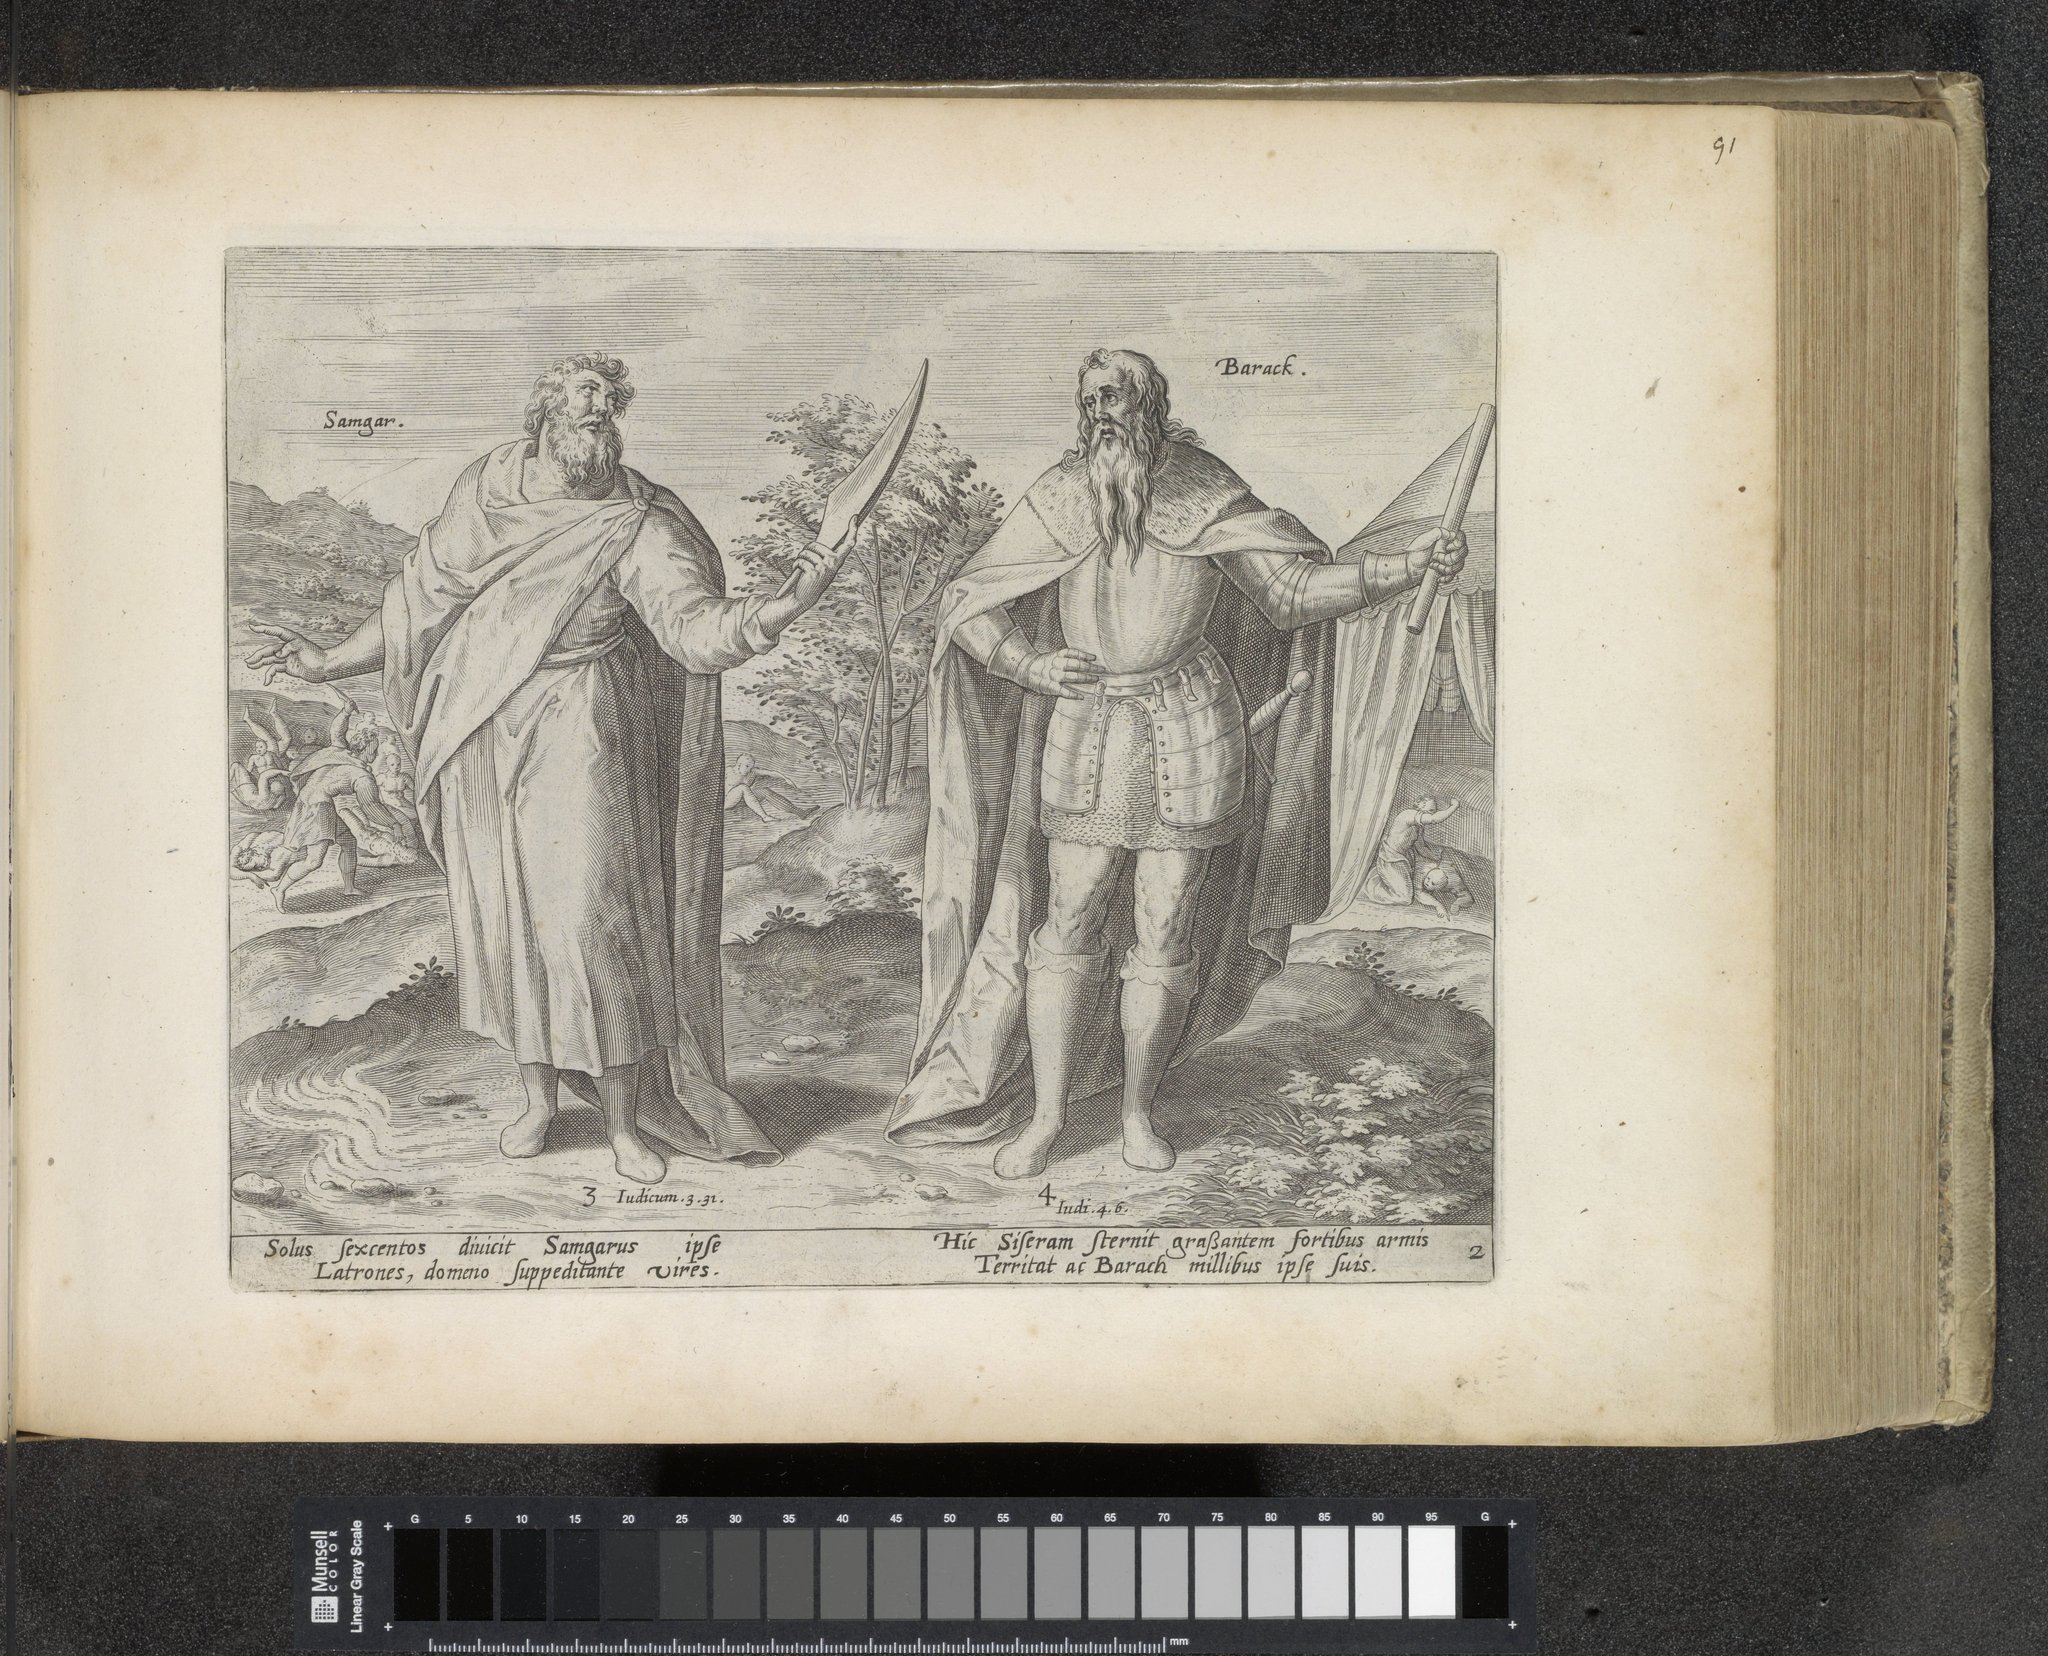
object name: album leaf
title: Theatrum Biblicum Hoc Est Historiae Sacrae Veteris et Novi Testamenti Tabulis Aeneis Expressae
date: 1579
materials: paper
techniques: engraving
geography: amsterdam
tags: the time of deborah and barak (judges 4-5), shamgar slays six hundred philistines with an ox goad, jael kills the sleeping sisera by hitting the nail through his temples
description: De rechters Samgar en Barak. Samgar houdt een ossenprik in de hand en op de achtergrond doodt hij daarmee zeshonderd Filistijnen. Barak is gekleed in harnas en houdt een scepter in de hand. Rechts op de achtergrond doodt Jaël Sisera door een tentpin door zijn hoofd te slaan als hij slaapt. Onder de voorstelling toelichtende teksten in het Latijn en verwijzingen naar de Bijbelteksten in Ri. 3:31 en Ri. 4:6. Deze prent maakt deel uit van een album.